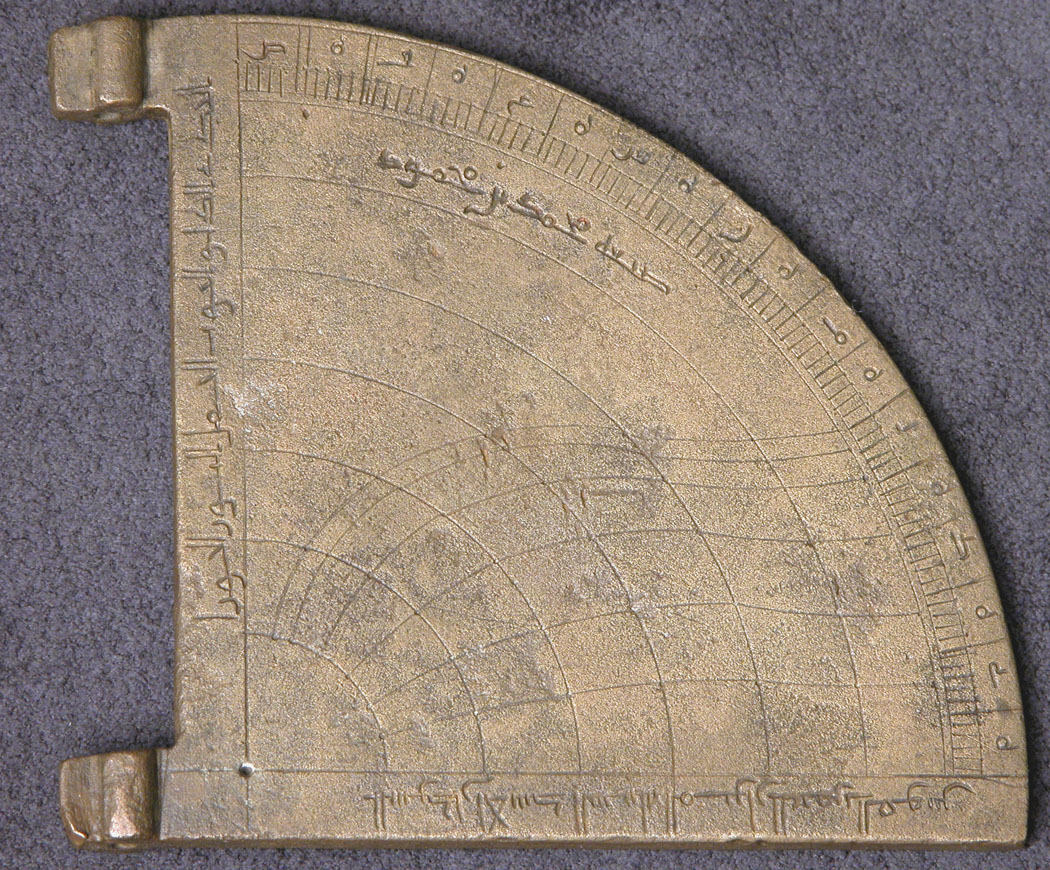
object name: quadrant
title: Horary Quadrant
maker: muhammad ibn mahmud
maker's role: maker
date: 901-1000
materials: brass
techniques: casting, incising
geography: iran